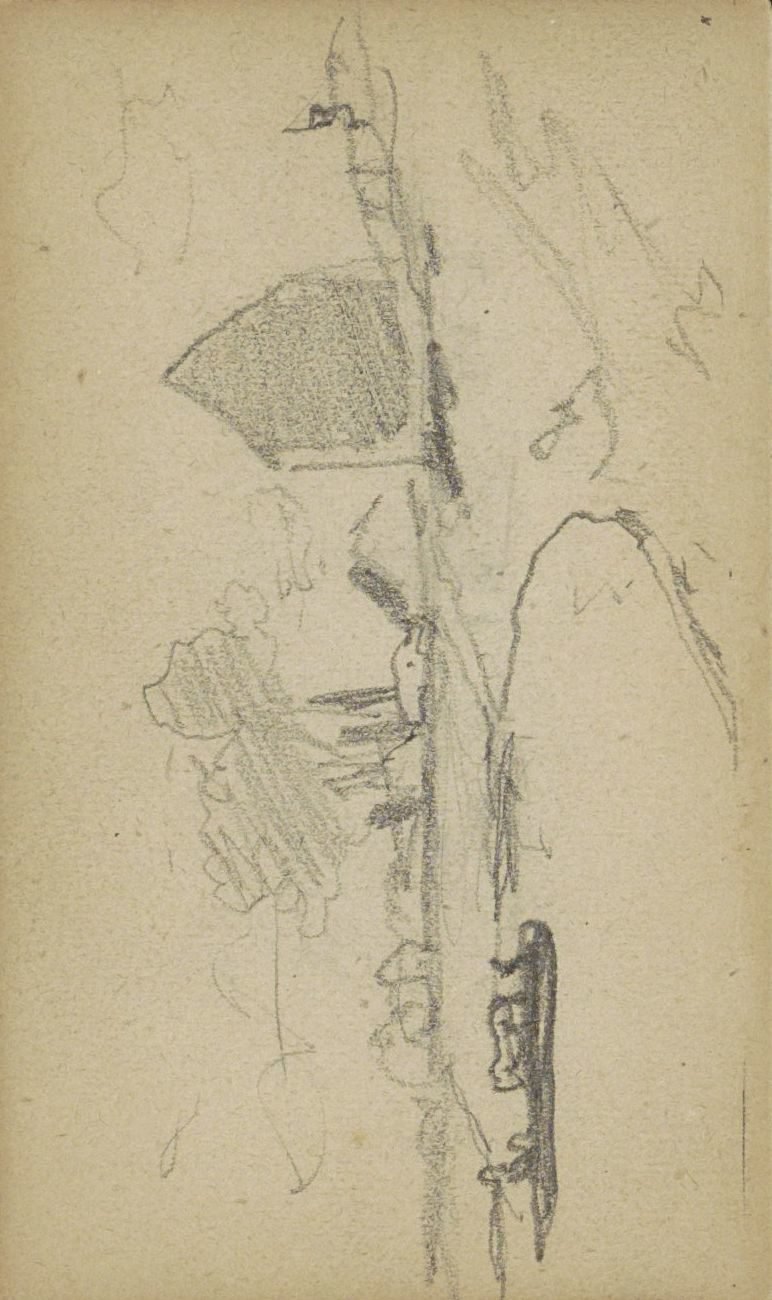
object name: sketchbook leaf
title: Huizen op een dijk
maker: johan hendrik weissenbruch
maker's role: draughtsman, painter, print maker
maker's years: 1824-1903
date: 1834-1903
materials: paper, pencil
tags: rowing-boat, canoe, etc., dikes, levee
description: Op het water een roeiboot met figuren. Blad 19 verso uit een schetsboek met 32 bladen.